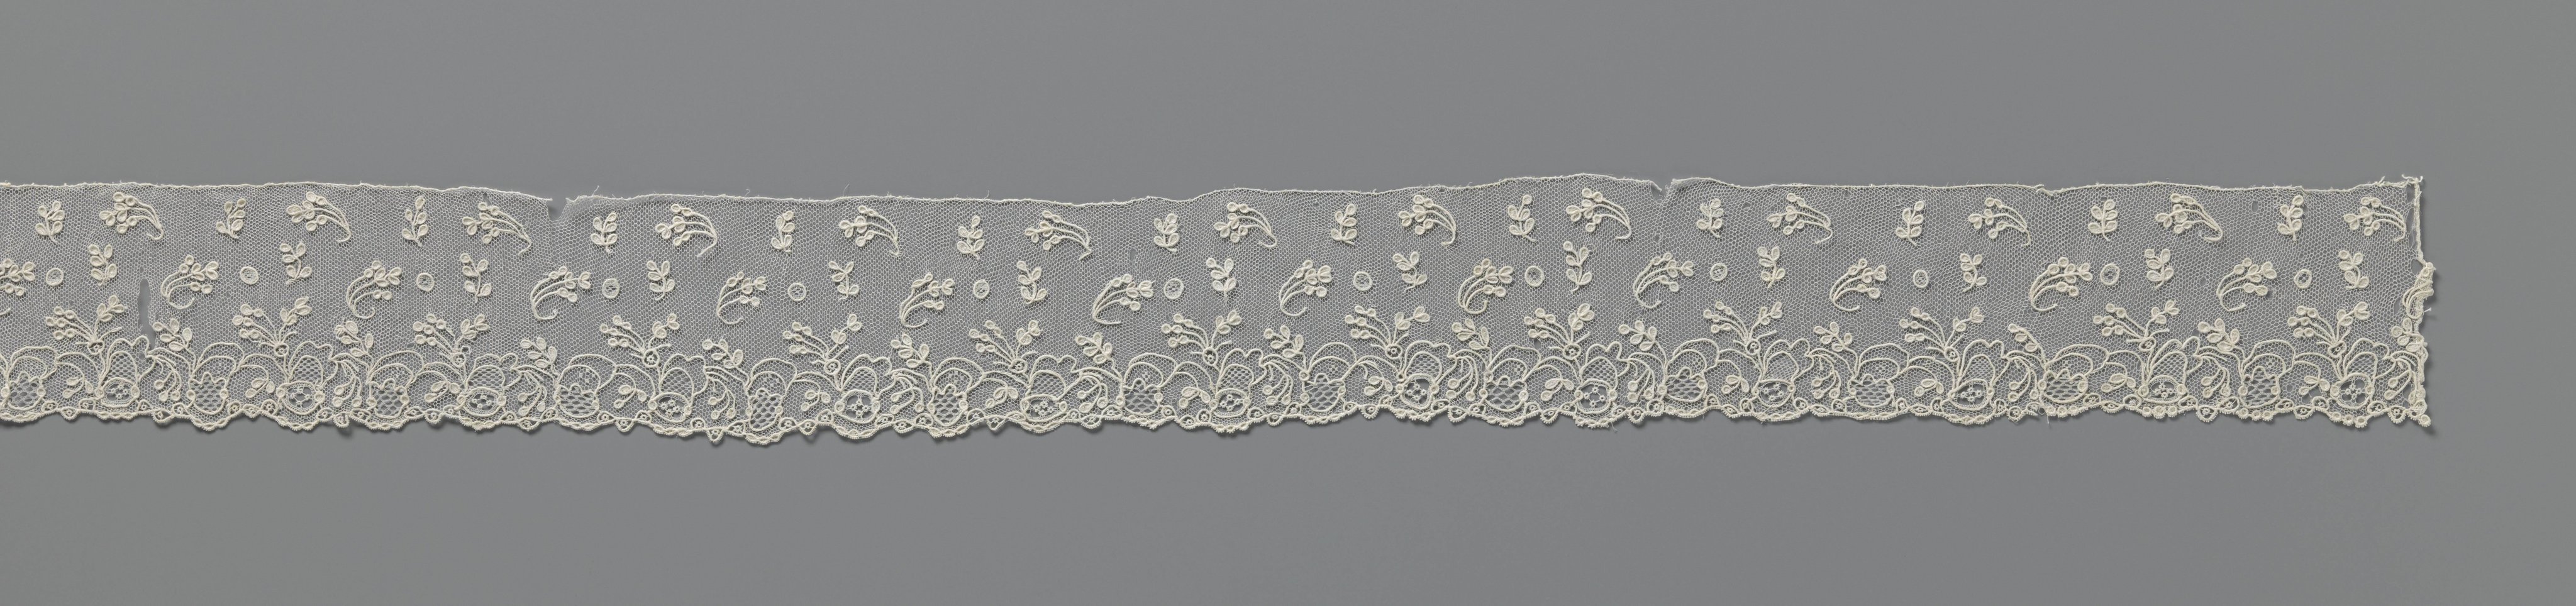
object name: strip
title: Strook naaldkant met rijen gestrooide bladertakken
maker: Anonymous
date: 1775-1799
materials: linen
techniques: lace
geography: france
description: Strook naturelkleurige naaldkant: Alençon-kant. Patroon met rijen gestrooide bladertakken op een fijne zeshoekige maasgrond. Het patroon aan de onderkant van de strook bestaat uit door kromme takken aaneengeregen medaillons, opgevuld met verschillende siergronden. De bovenzijde is afgewerkt met een rechte rand. De onderzijde is afgewerkt met een schulpenrand die voortkomt uit het patroon.